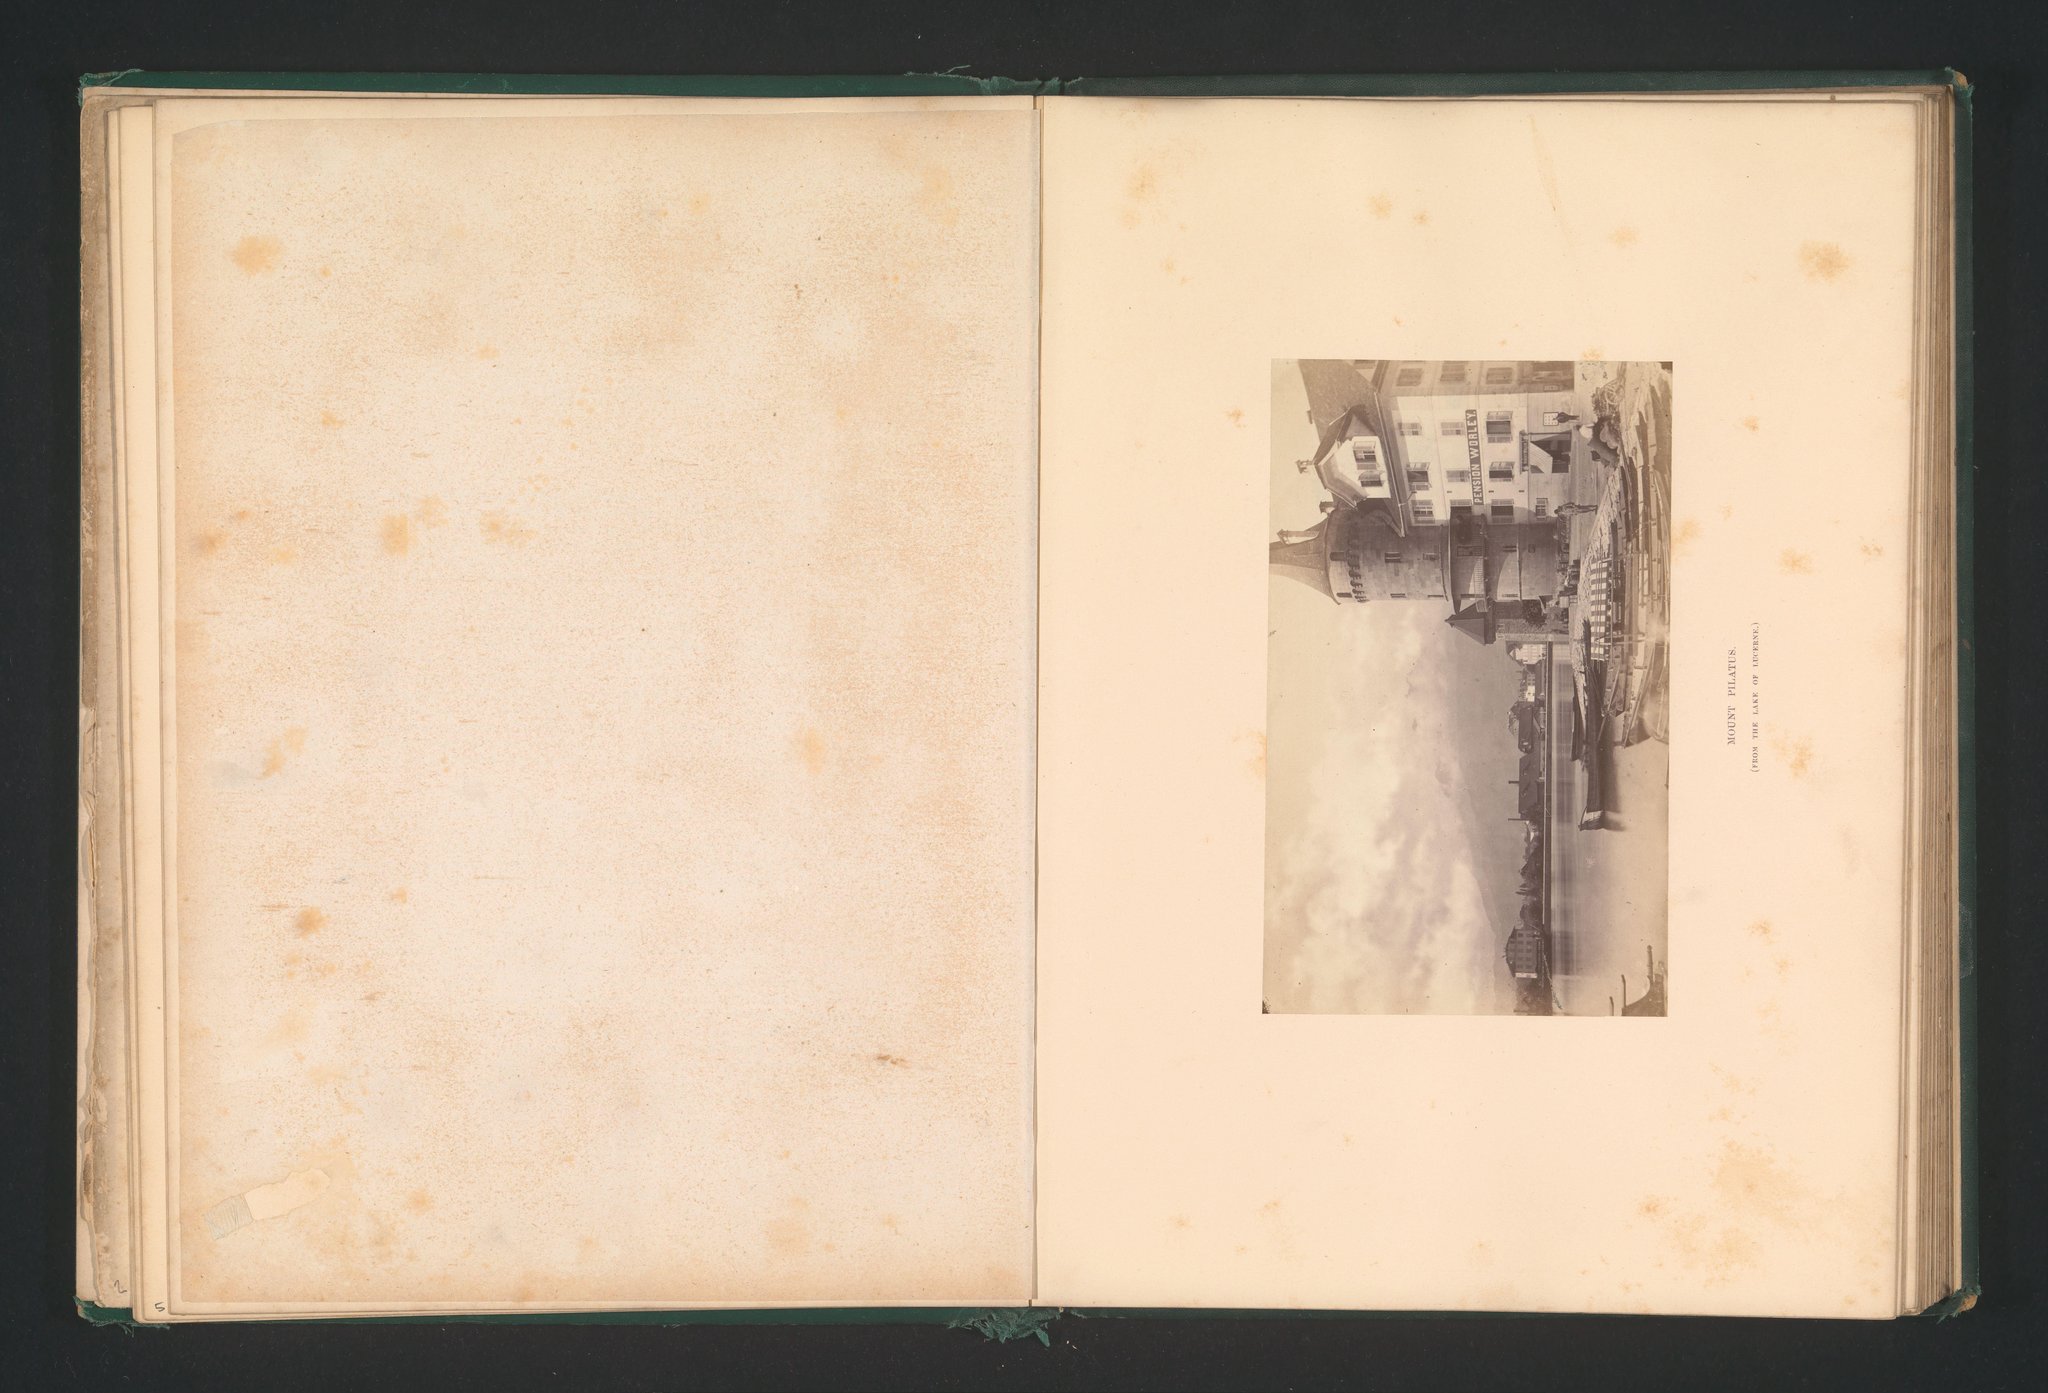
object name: page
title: Stadsgezicht met de Pilatus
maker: stephen thompson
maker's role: fotograaf, schrijver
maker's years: 1831-1893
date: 1863-1868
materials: photographic support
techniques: albumen print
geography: lucerne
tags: city-view in general; 'veduta', mountains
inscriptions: inscription: ‘(from the lake of Lucerne)’